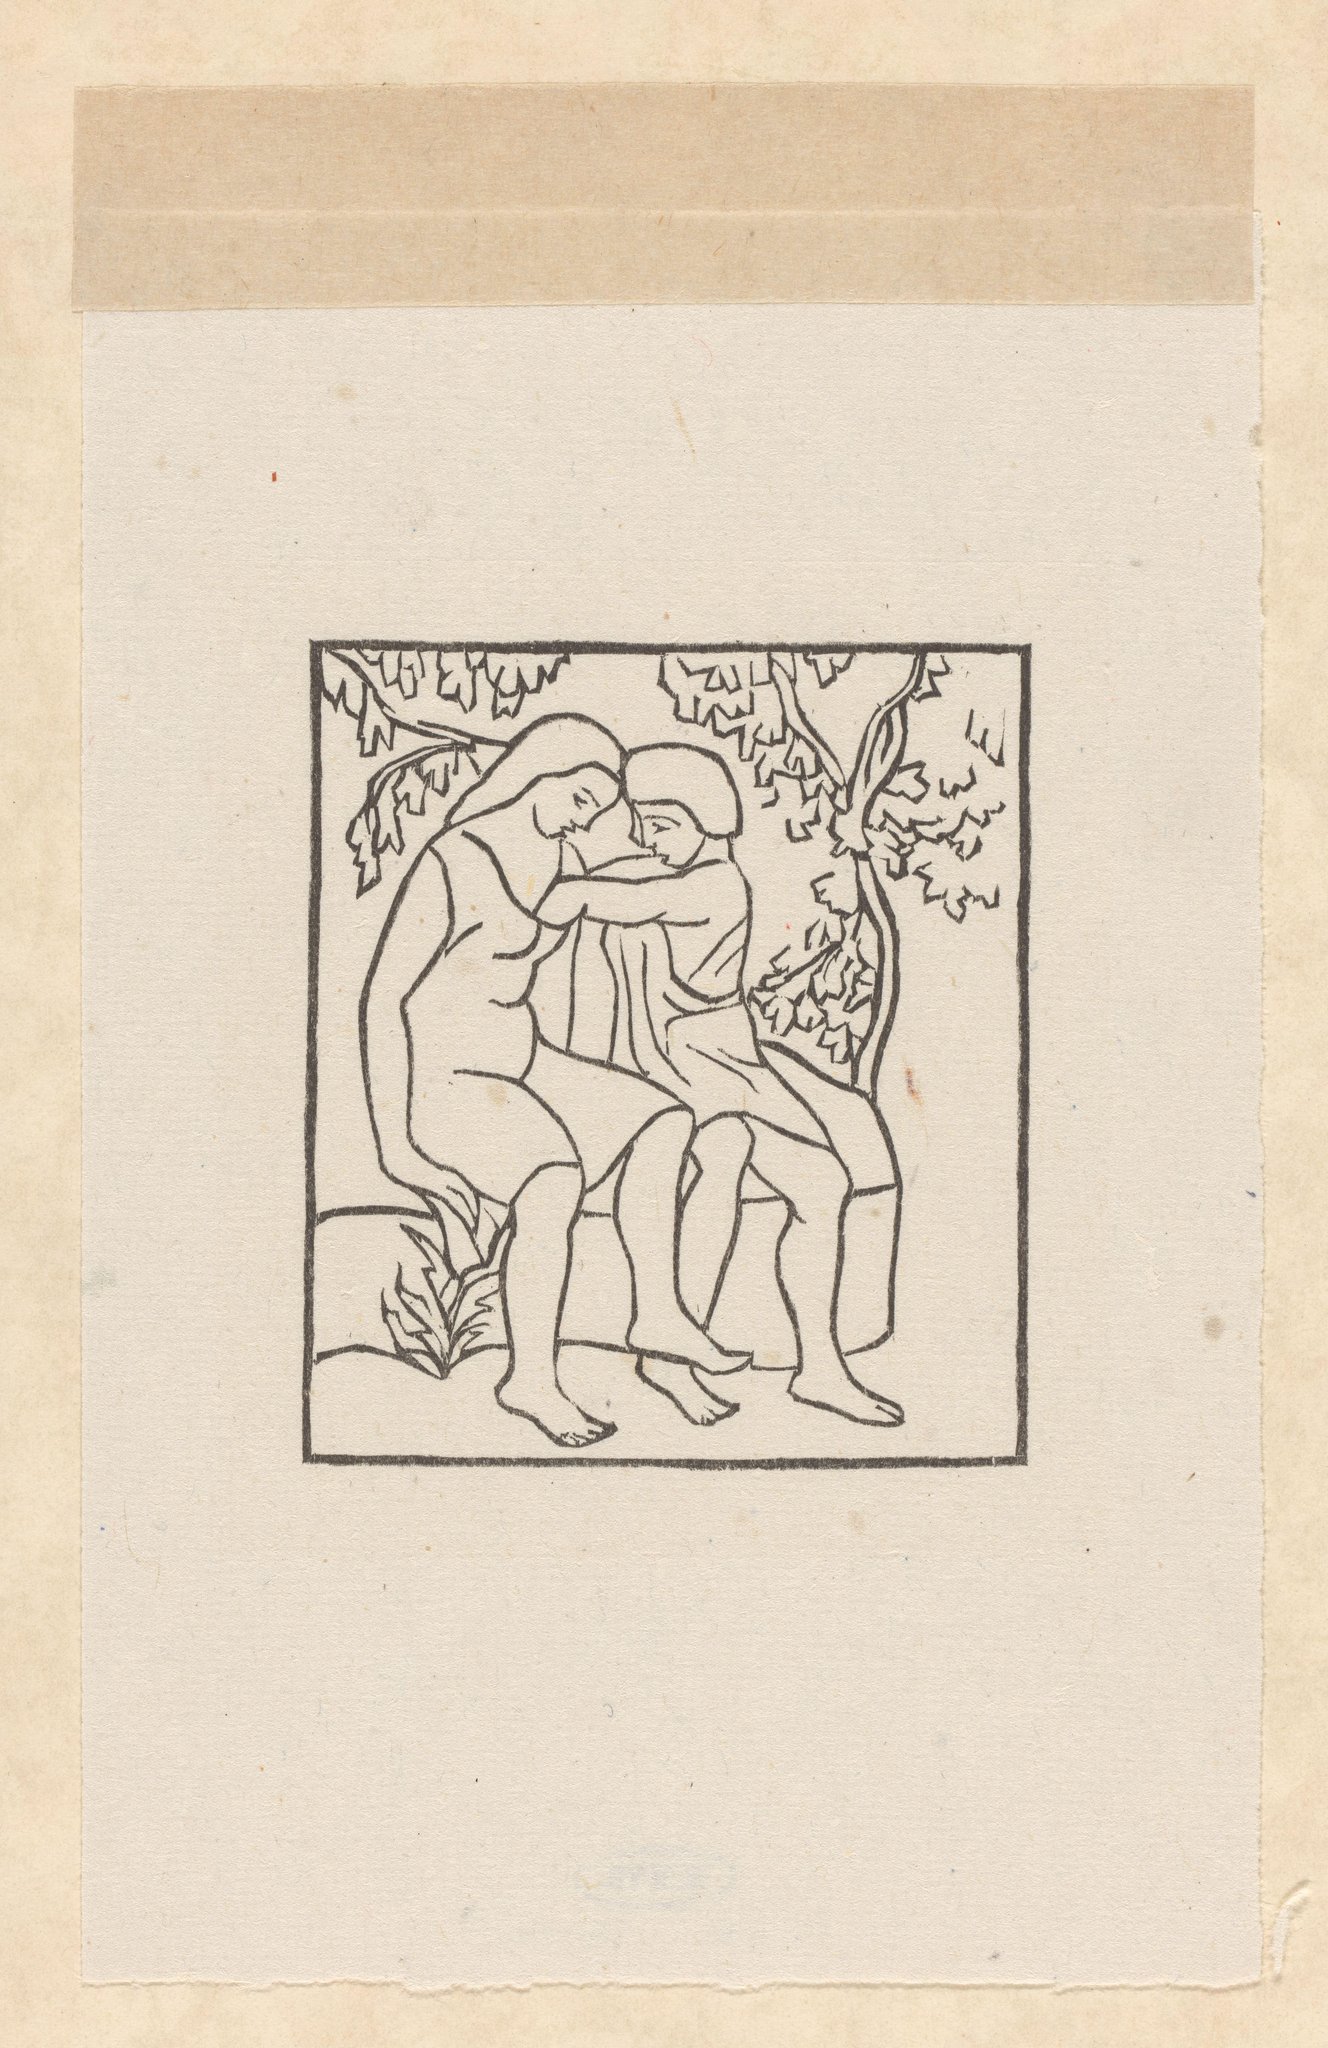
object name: print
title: Daphnis haalt een cicade uit de jurk van Chloë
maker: aristide maillol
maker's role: draughtsman, painter, print maker, sculptor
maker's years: 1861-1944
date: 1937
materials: paper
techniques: woodcut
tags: arm or hand held in front of the chest, insects: cicada, daphnis (in greek mythology a shepherd who invented pastoral poetry, chloe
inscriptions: collector's mark: Lugt 2228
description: Latere staat van deze prent gebruikt in: Longus. Les Pastorales de Longus ou Daphnis & Chloé. Parijs: Frères Gonin, 1935, p. 50.